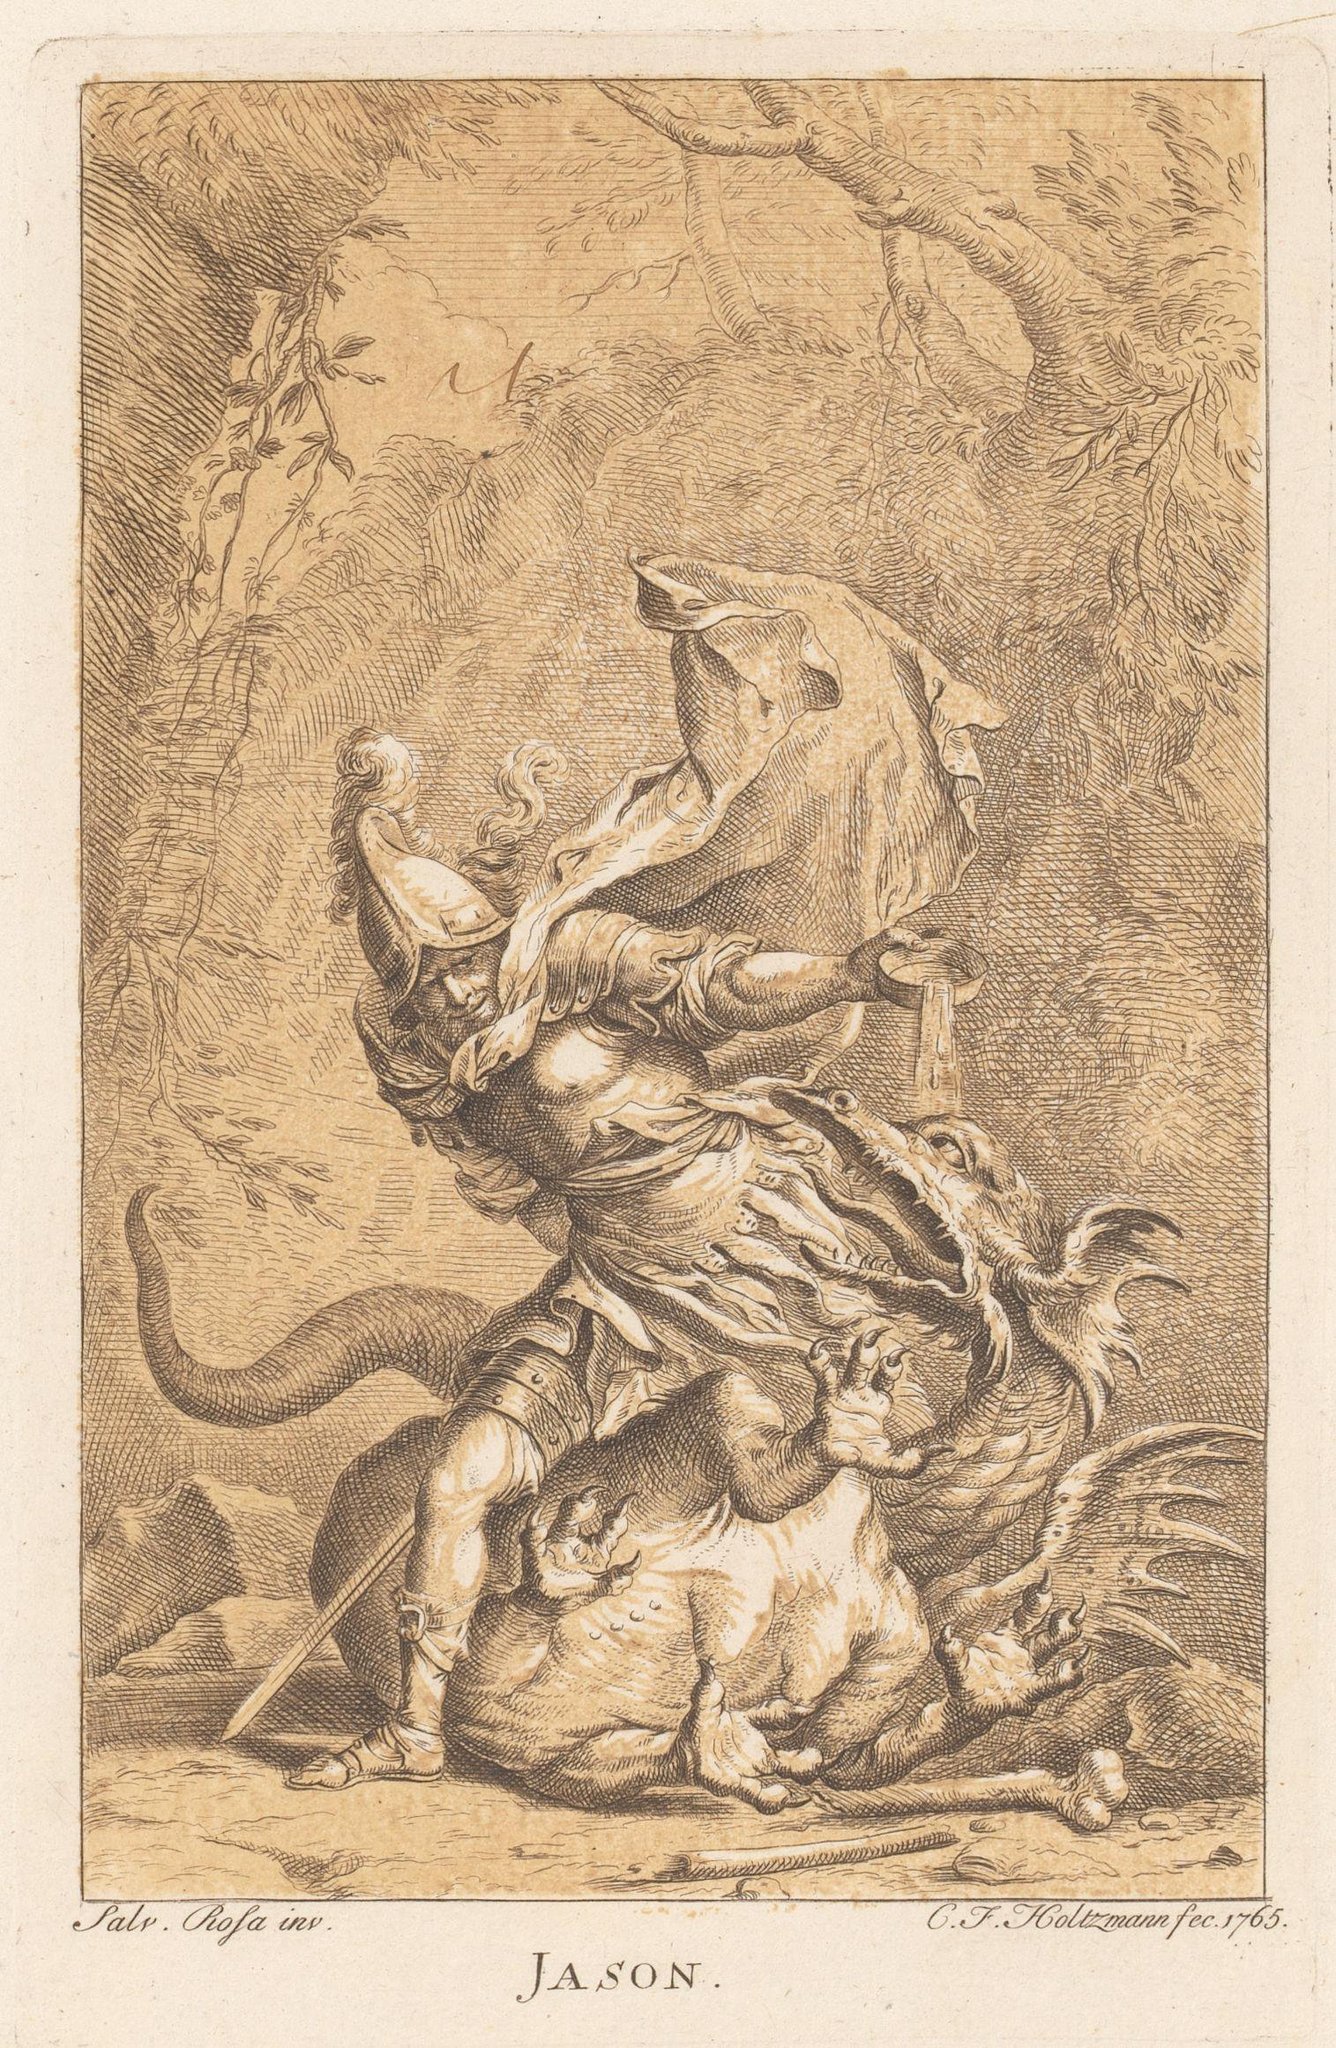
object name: print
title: Jason en de draak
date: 1765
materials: paper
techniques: etching, intaglio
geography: dresden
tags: fight with the dragon; jason sprinkles a drug in its eyes, possibly assisted by medea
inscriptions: annotation, collector's mark: Lugt 2228, collector's mark: Lugt 2760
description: De prent waarop deze prent is gebaseerd komt mogelijk uit een serie door Salvator Rosa getiteld 'Figurine' uit 1656-1657.